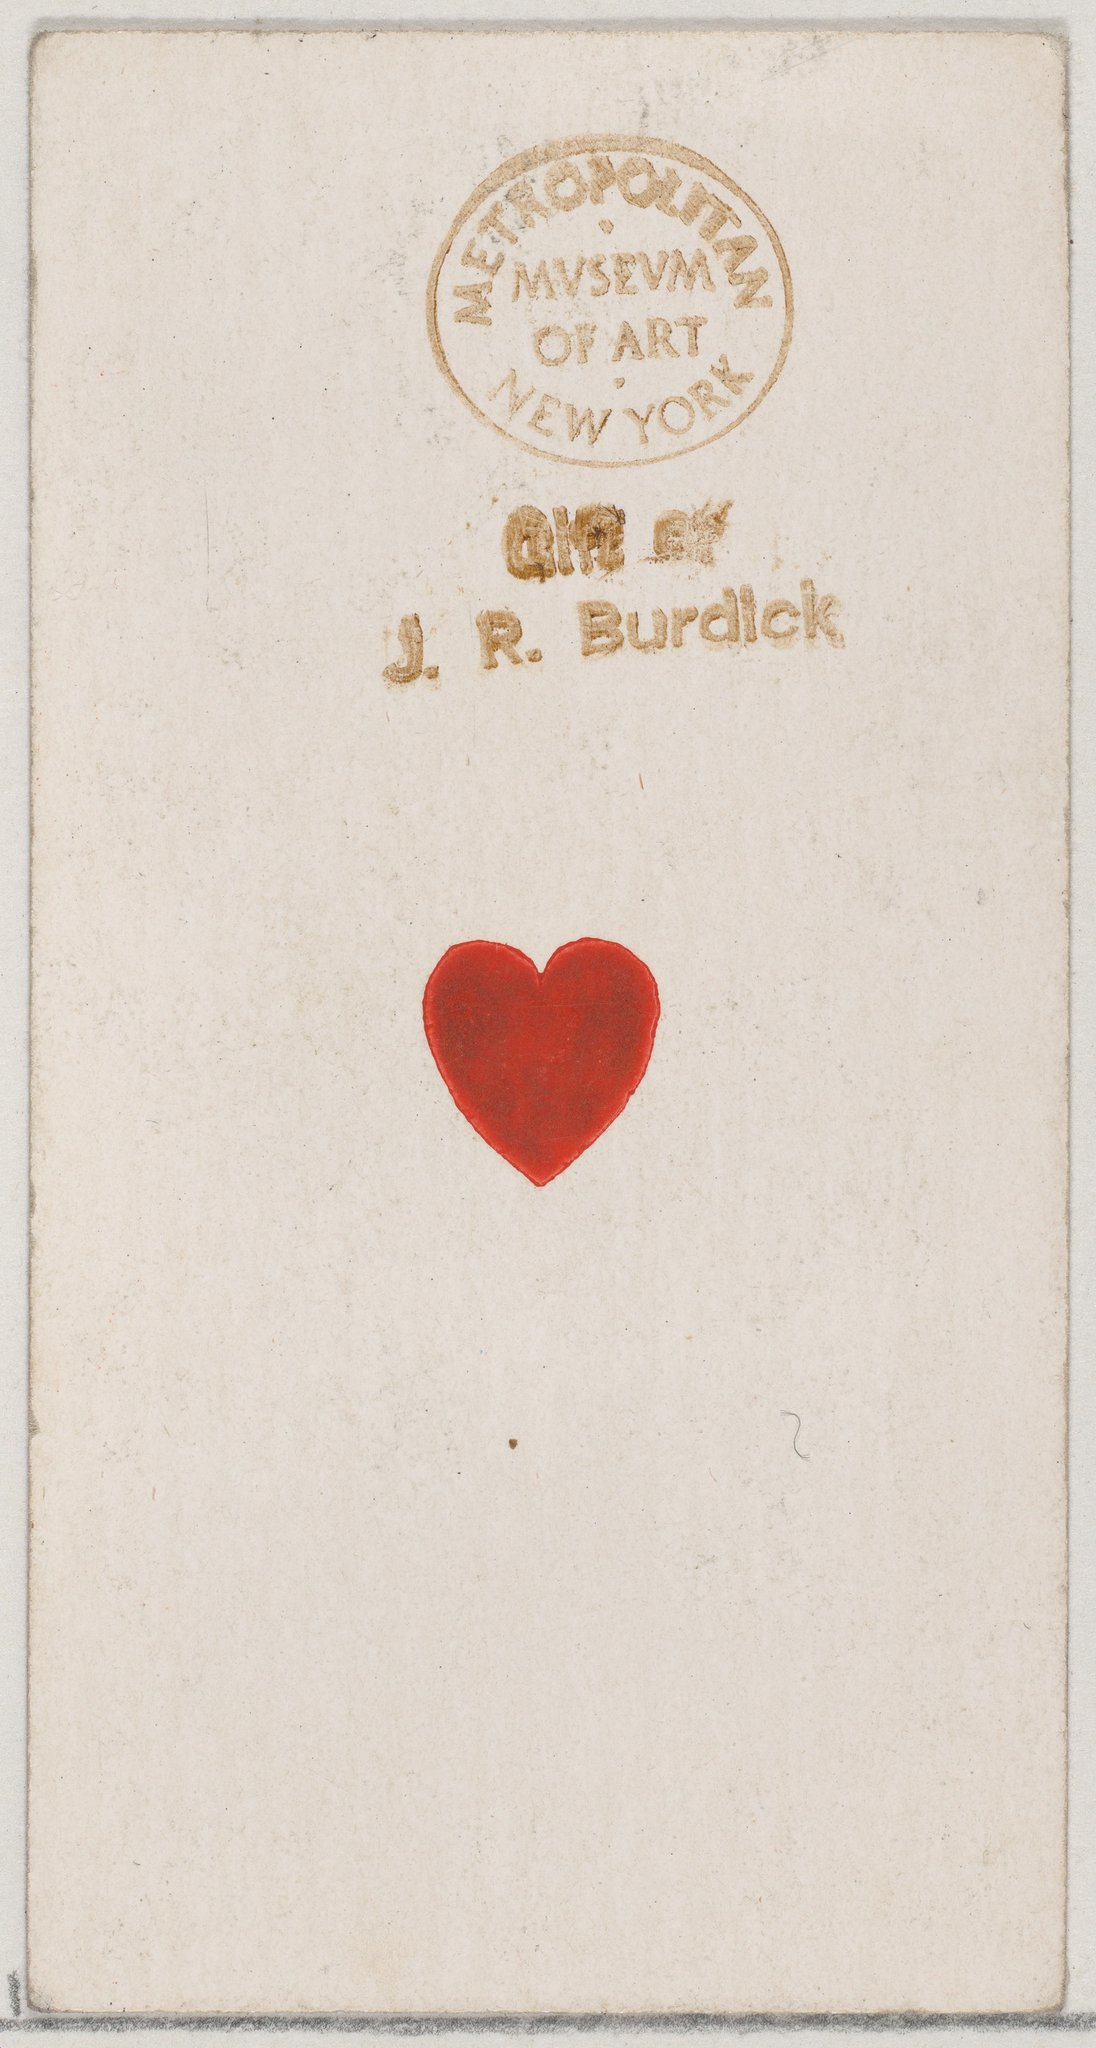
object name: print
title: One Heart, from the Playing Cards series (N84) to promote Turkish Cross-Cut Cigarettes for W. Duke, Sons and Co.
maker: w. duke, sons & co.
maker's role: publisher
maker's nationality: american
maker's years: 1870-1920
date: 1888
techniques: color lithograph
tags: playing cards